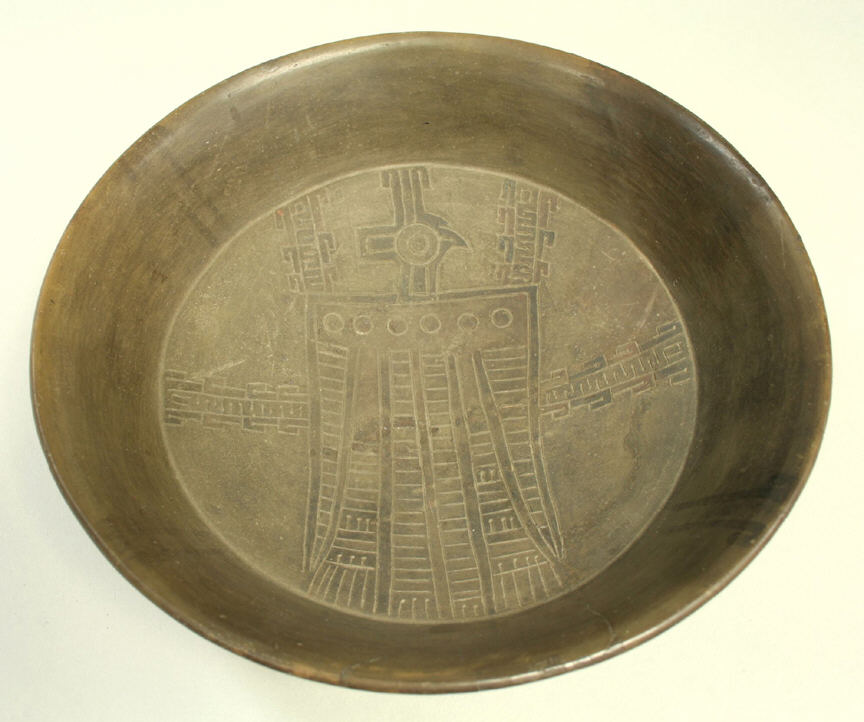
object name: bowl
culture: paracas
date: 700-201 BCE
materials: ceramic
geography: peru